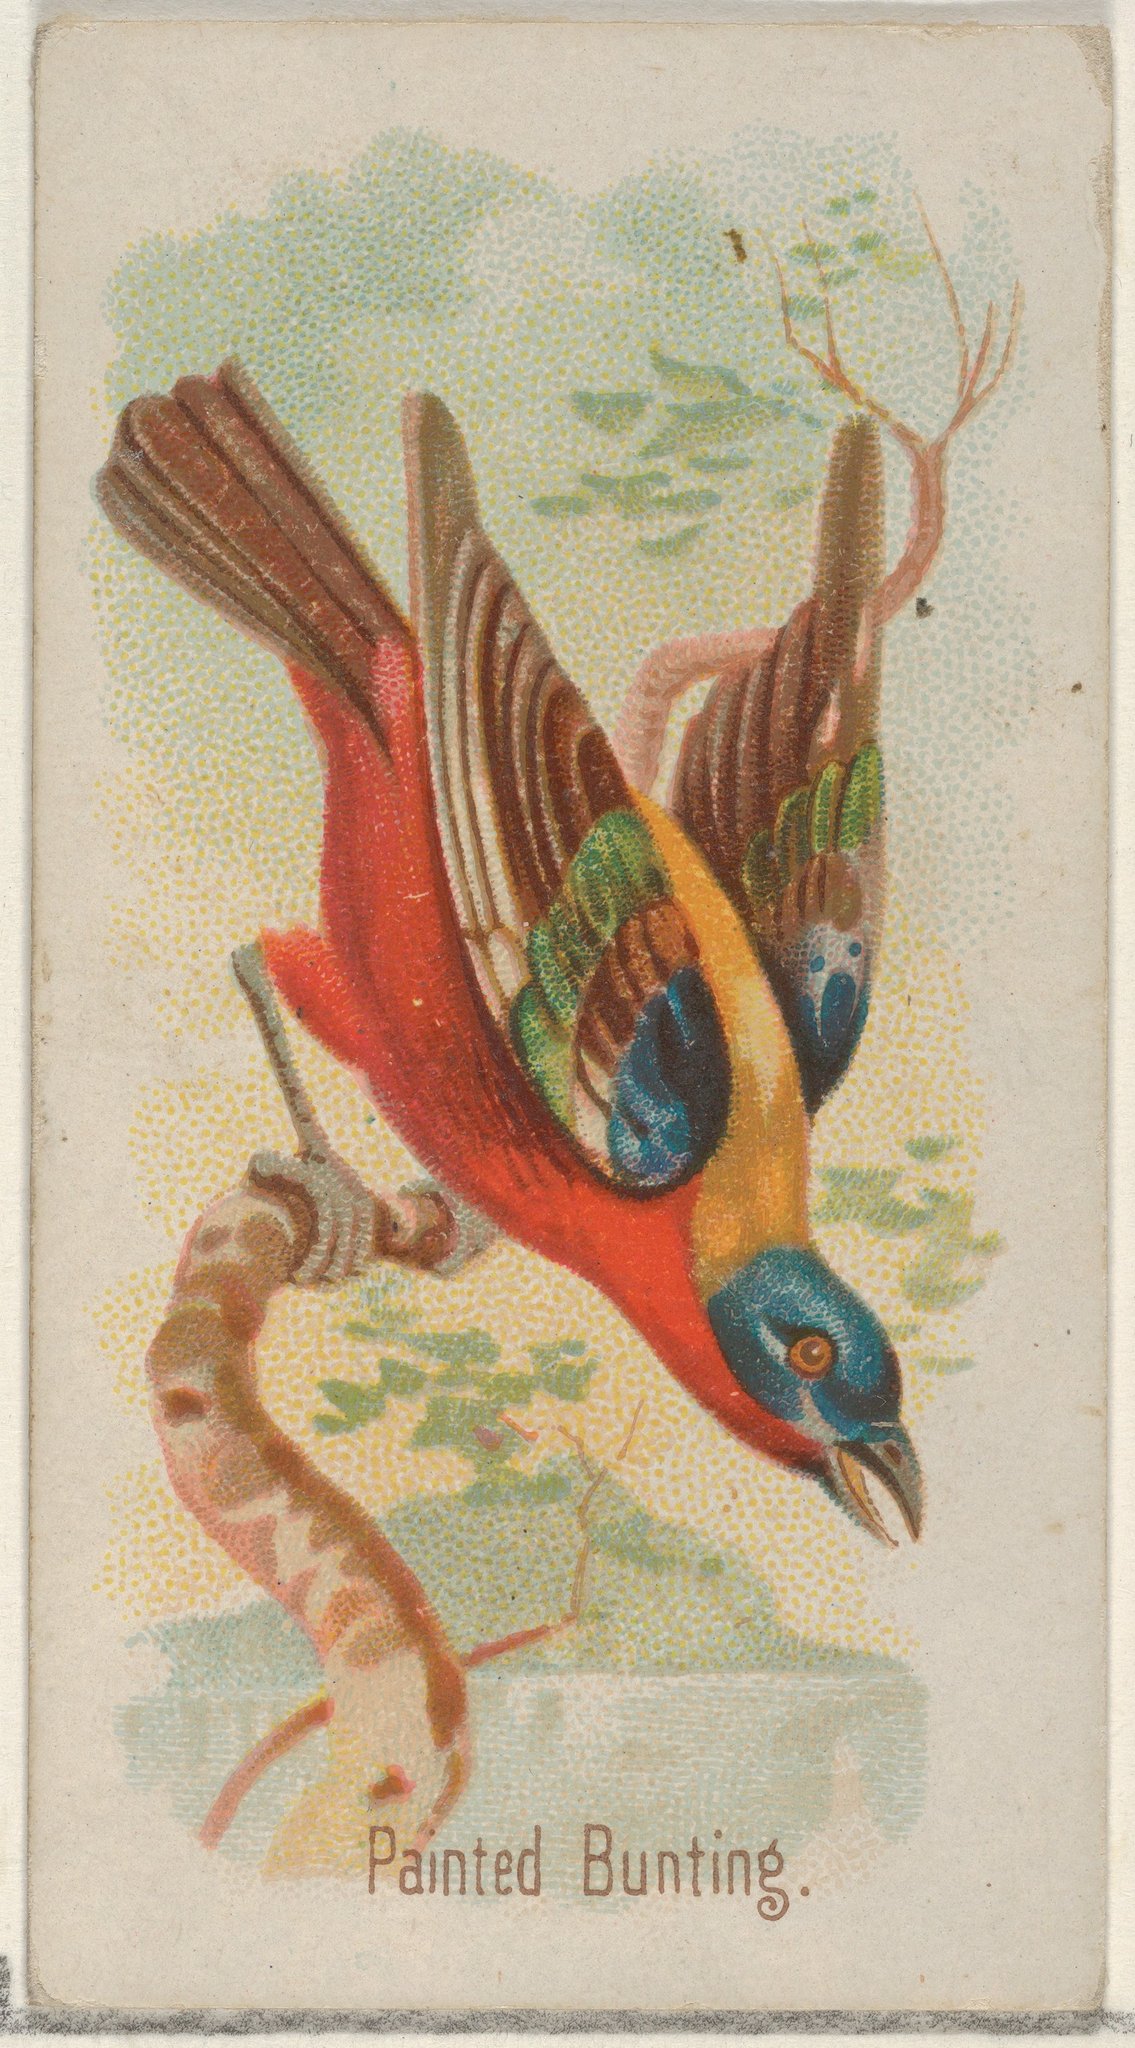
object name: print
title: Painted Bunting, from the Song Birds of the World series (N23) for Allen & Ginter Cigarettes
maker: allen & ginter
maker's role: publisher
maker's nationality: american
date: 1890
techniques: color lithograph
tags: birds